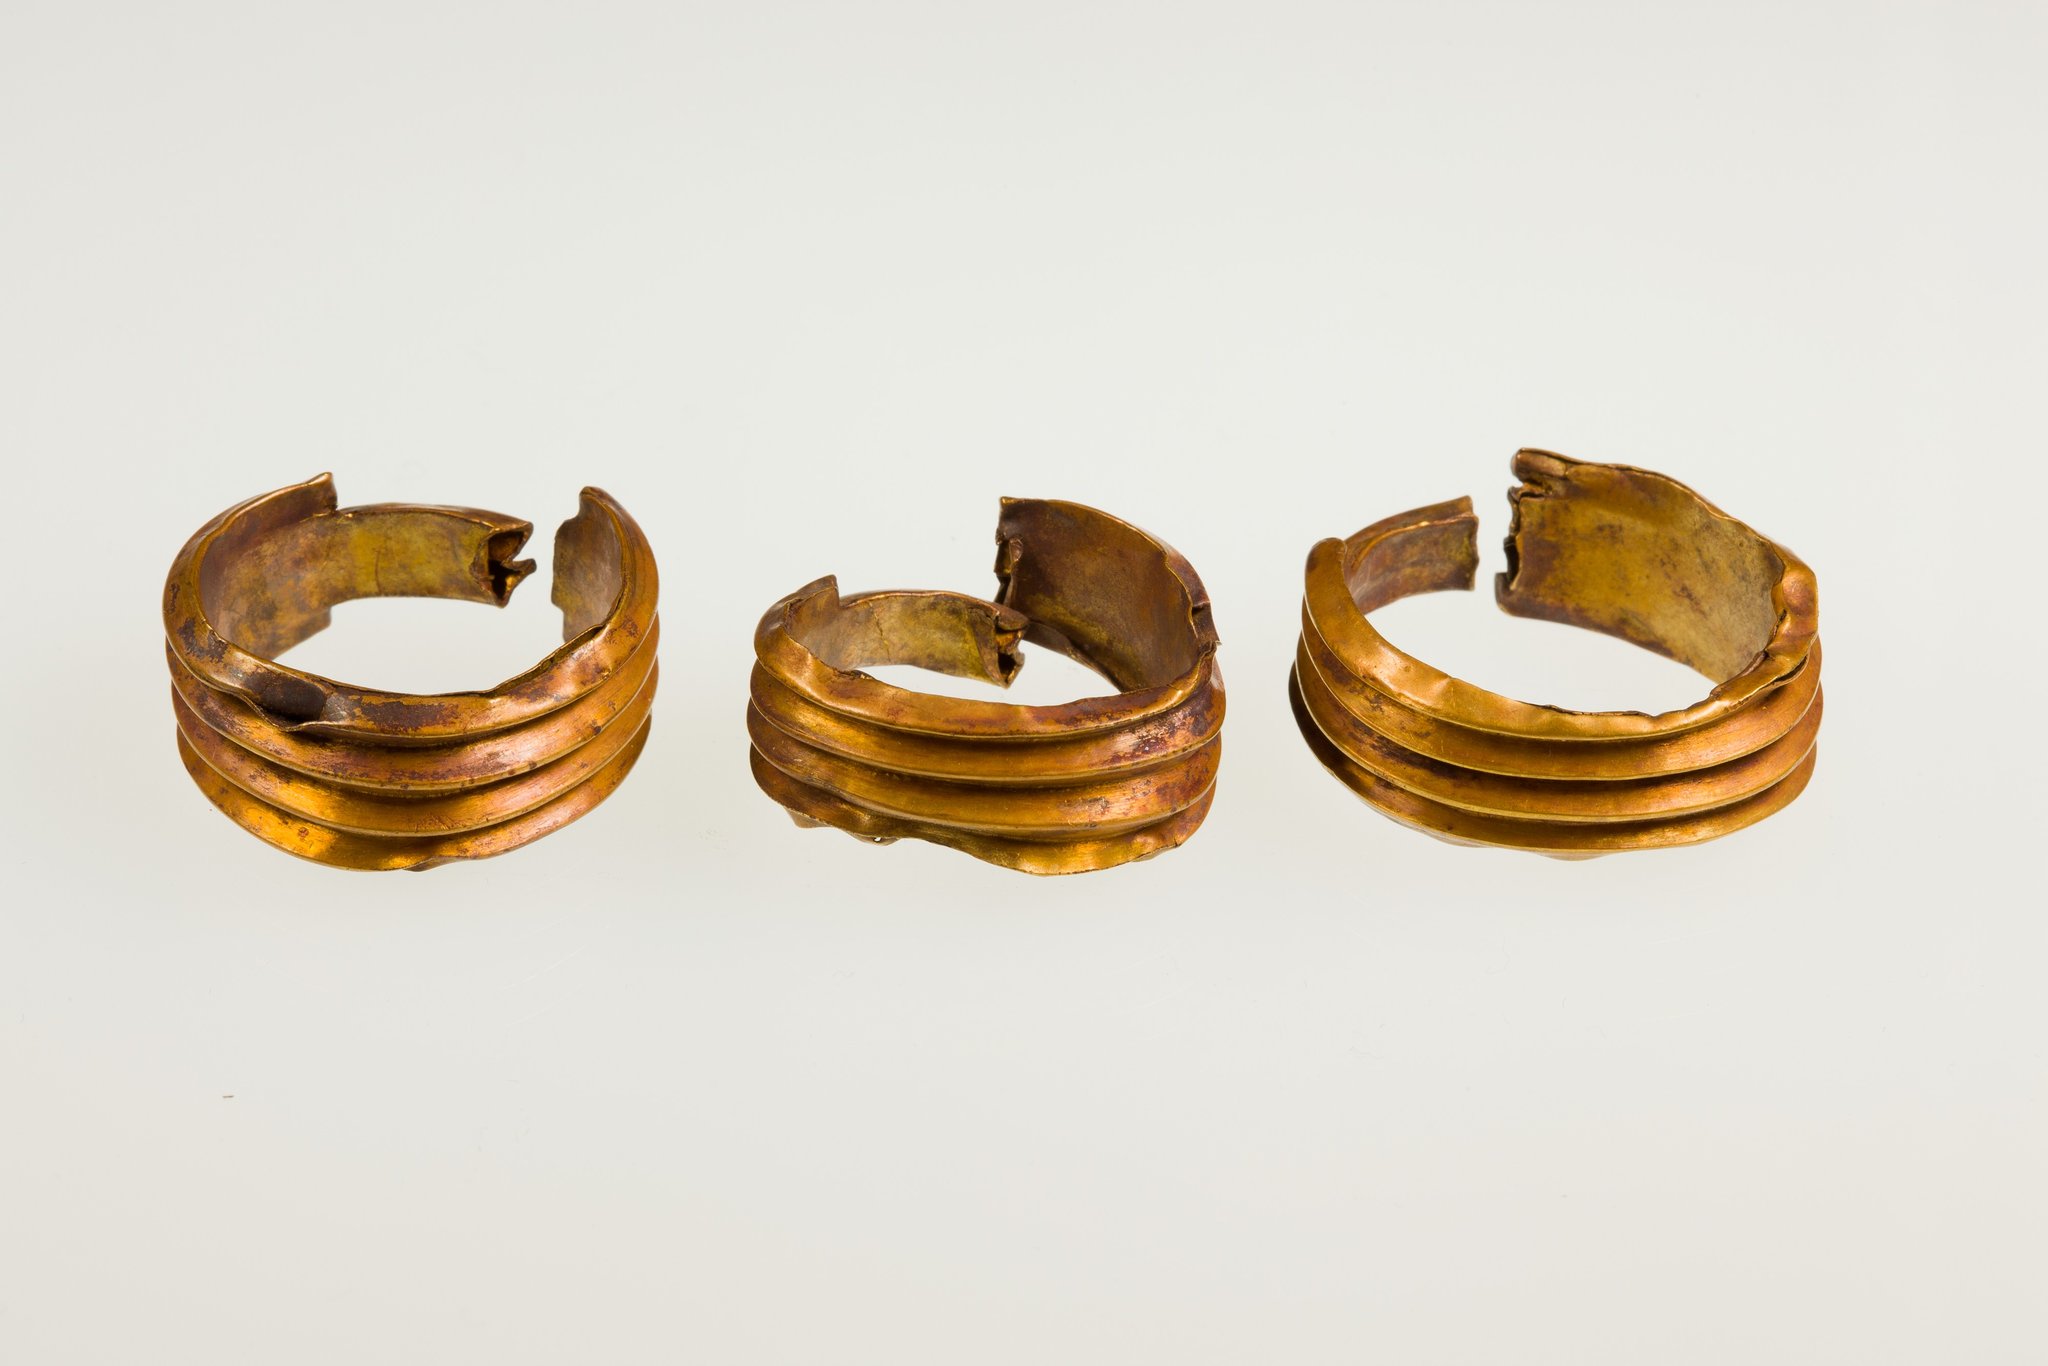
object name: earring, penannular, ribbed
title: Ribbed Penannular Earring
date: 1550-1425 BCE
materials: gold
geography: egypt